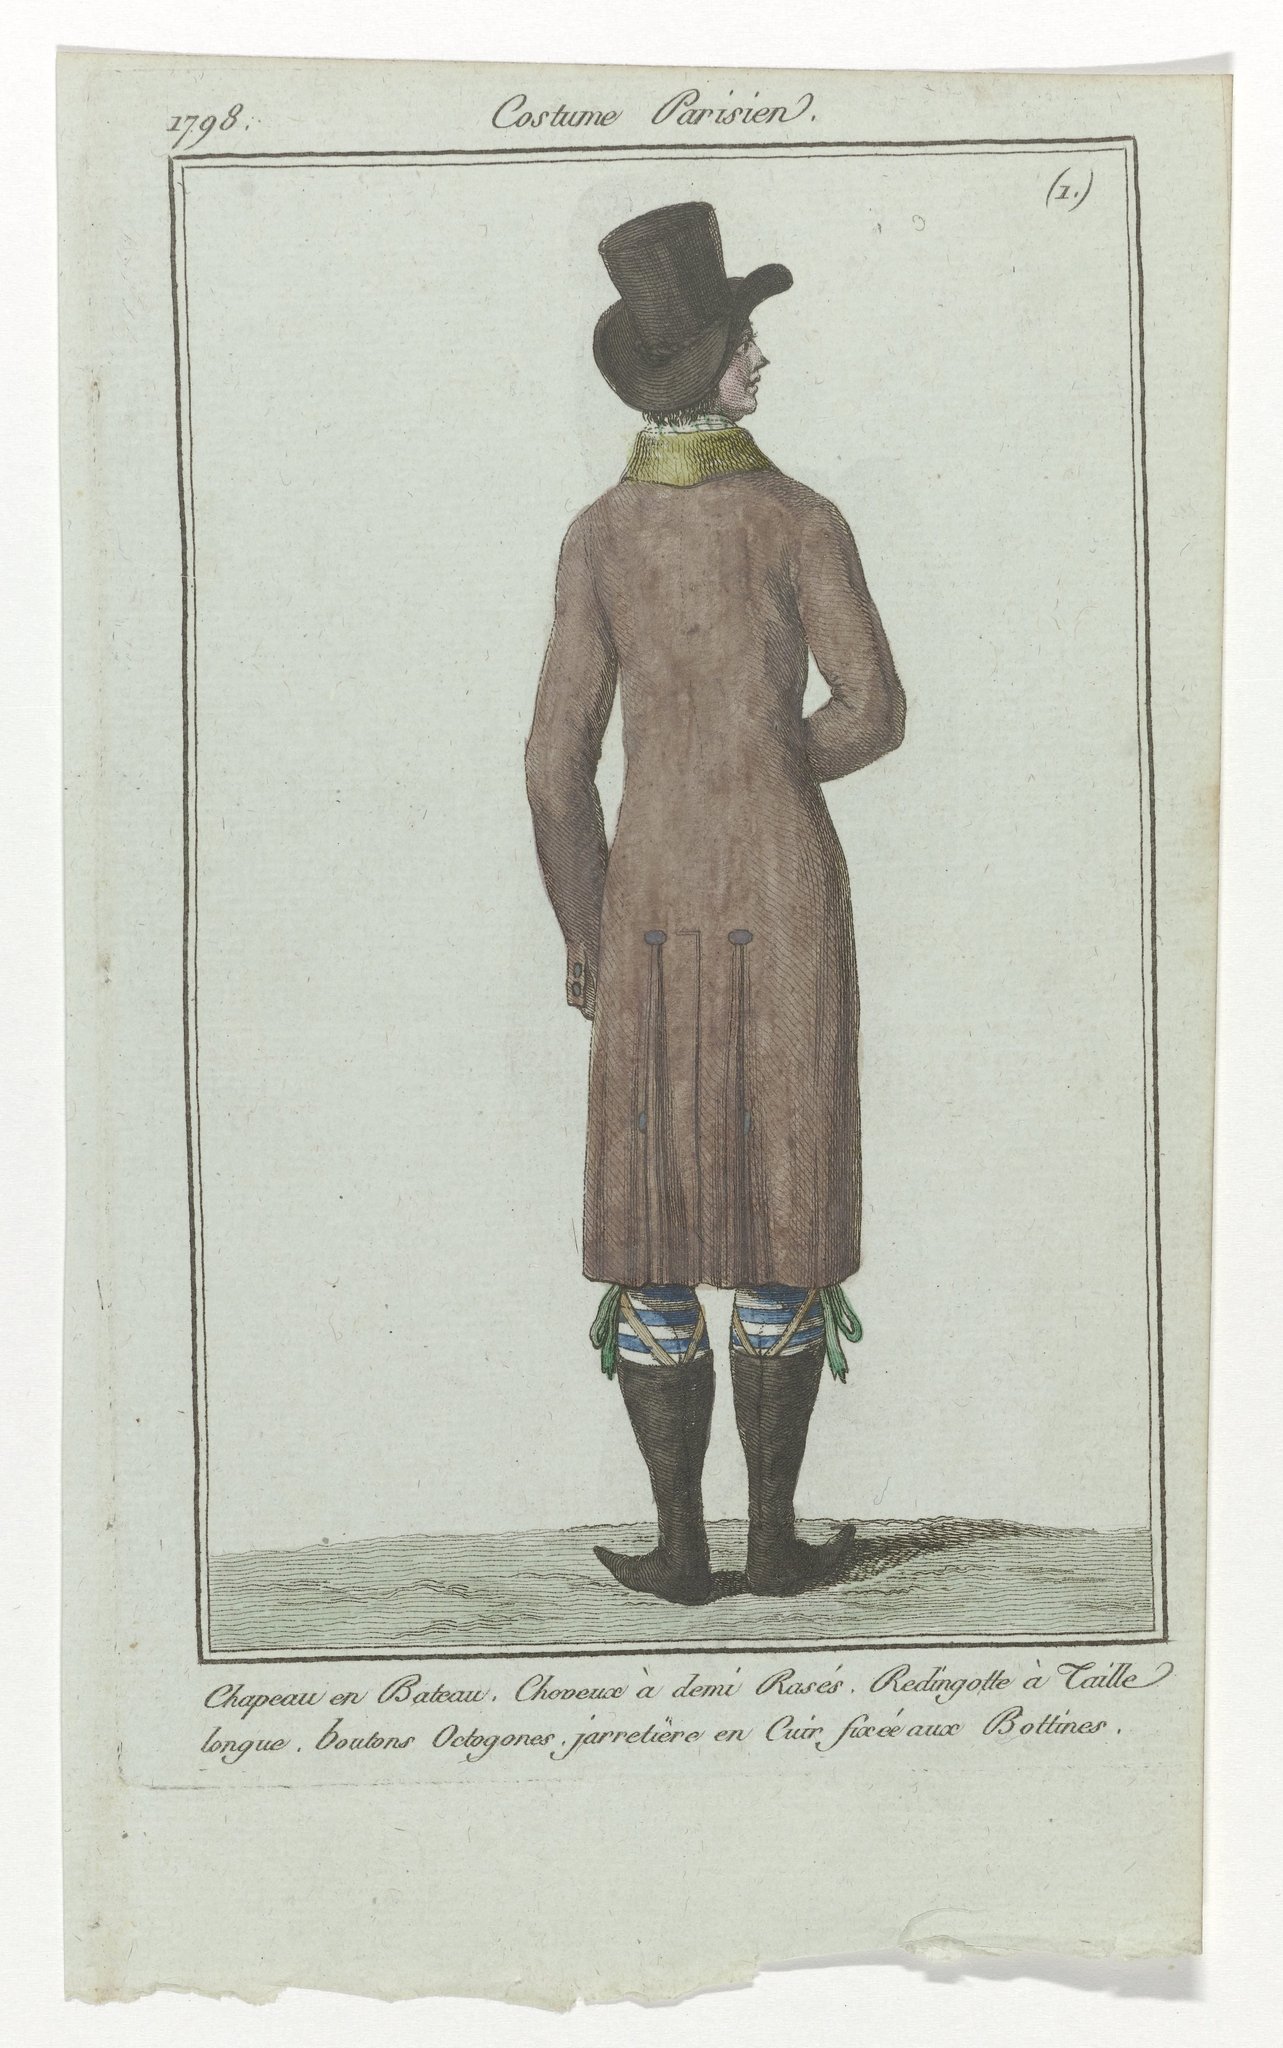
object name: fashion print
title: Journal des Dames et des Modes, Costume Parisien, 8 janvier 1798, (1) : Chapeau en Bateau (...)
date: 1798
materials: paper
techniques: engraving, hand coloring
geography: paris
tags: neck-gear ~ clothing (neckerchief) (+ men's clothes), fasteners for clothes (+ men's clothes), coat: overcoat (+ men's clothes), head-gear: hat (+ men's clothes), styles of hairdress, fashion plates, boots (+ men's clothes), stockings, socks (+ men's clothes)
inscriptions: caption: ‘Chapeau en Bateau. Cheveux à demi Rasés, Redingotte à Taille longue. Boutons Octogones. jarretière en Cuir fixée aux Bottines.’, title: ‘Costume Parisien.’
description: Hoge hoed met de naam 'Chapeau en Bateau'. Redingote met lage taille en achthoekige knopen. Gestreepte kousen en leren kousenbanden aan laarzen met puntige neuzen. Om de hals een gestreepte halsdoek (?). De prent maakt deel uit van het modetijdschrift Journal des Dames et des Modes, uitgegeven door Sellèque, Parijs, 1797-1839